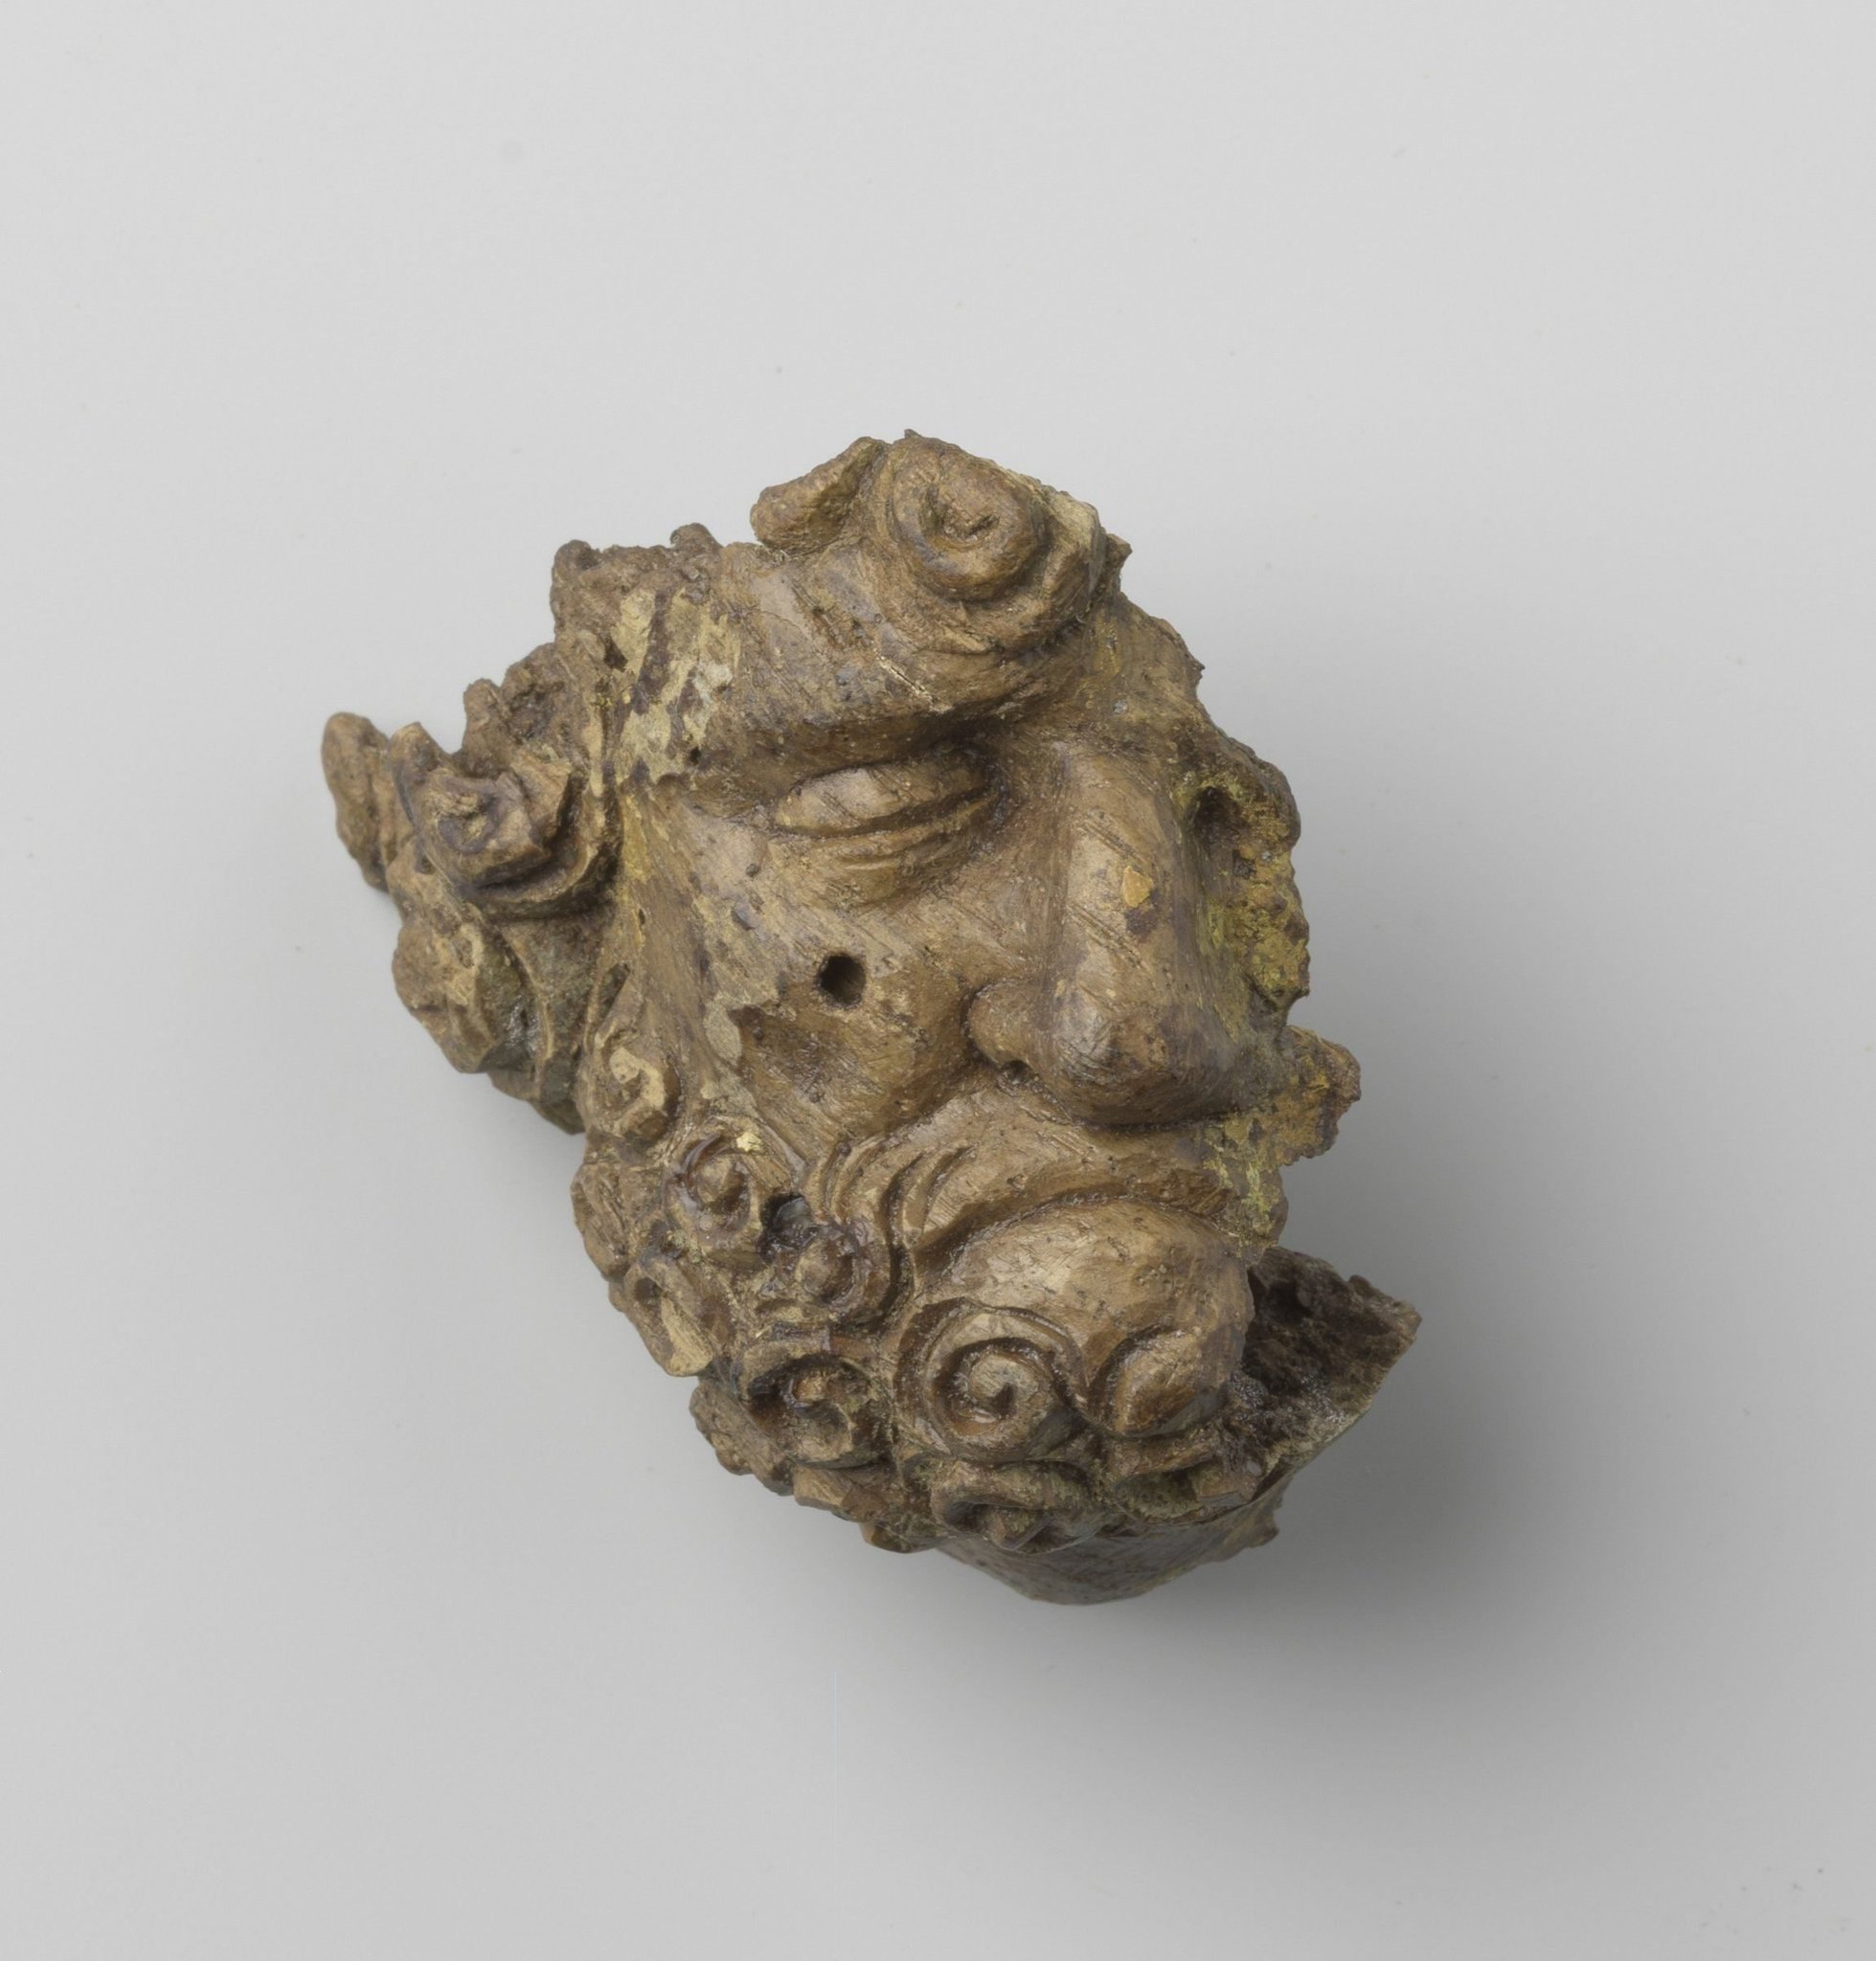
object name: fragment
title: Head of a Sleeping Disciple (St Peter?), from Christ in Gethsemane, from the Soest Altarpiece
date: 1475-1499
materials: wood